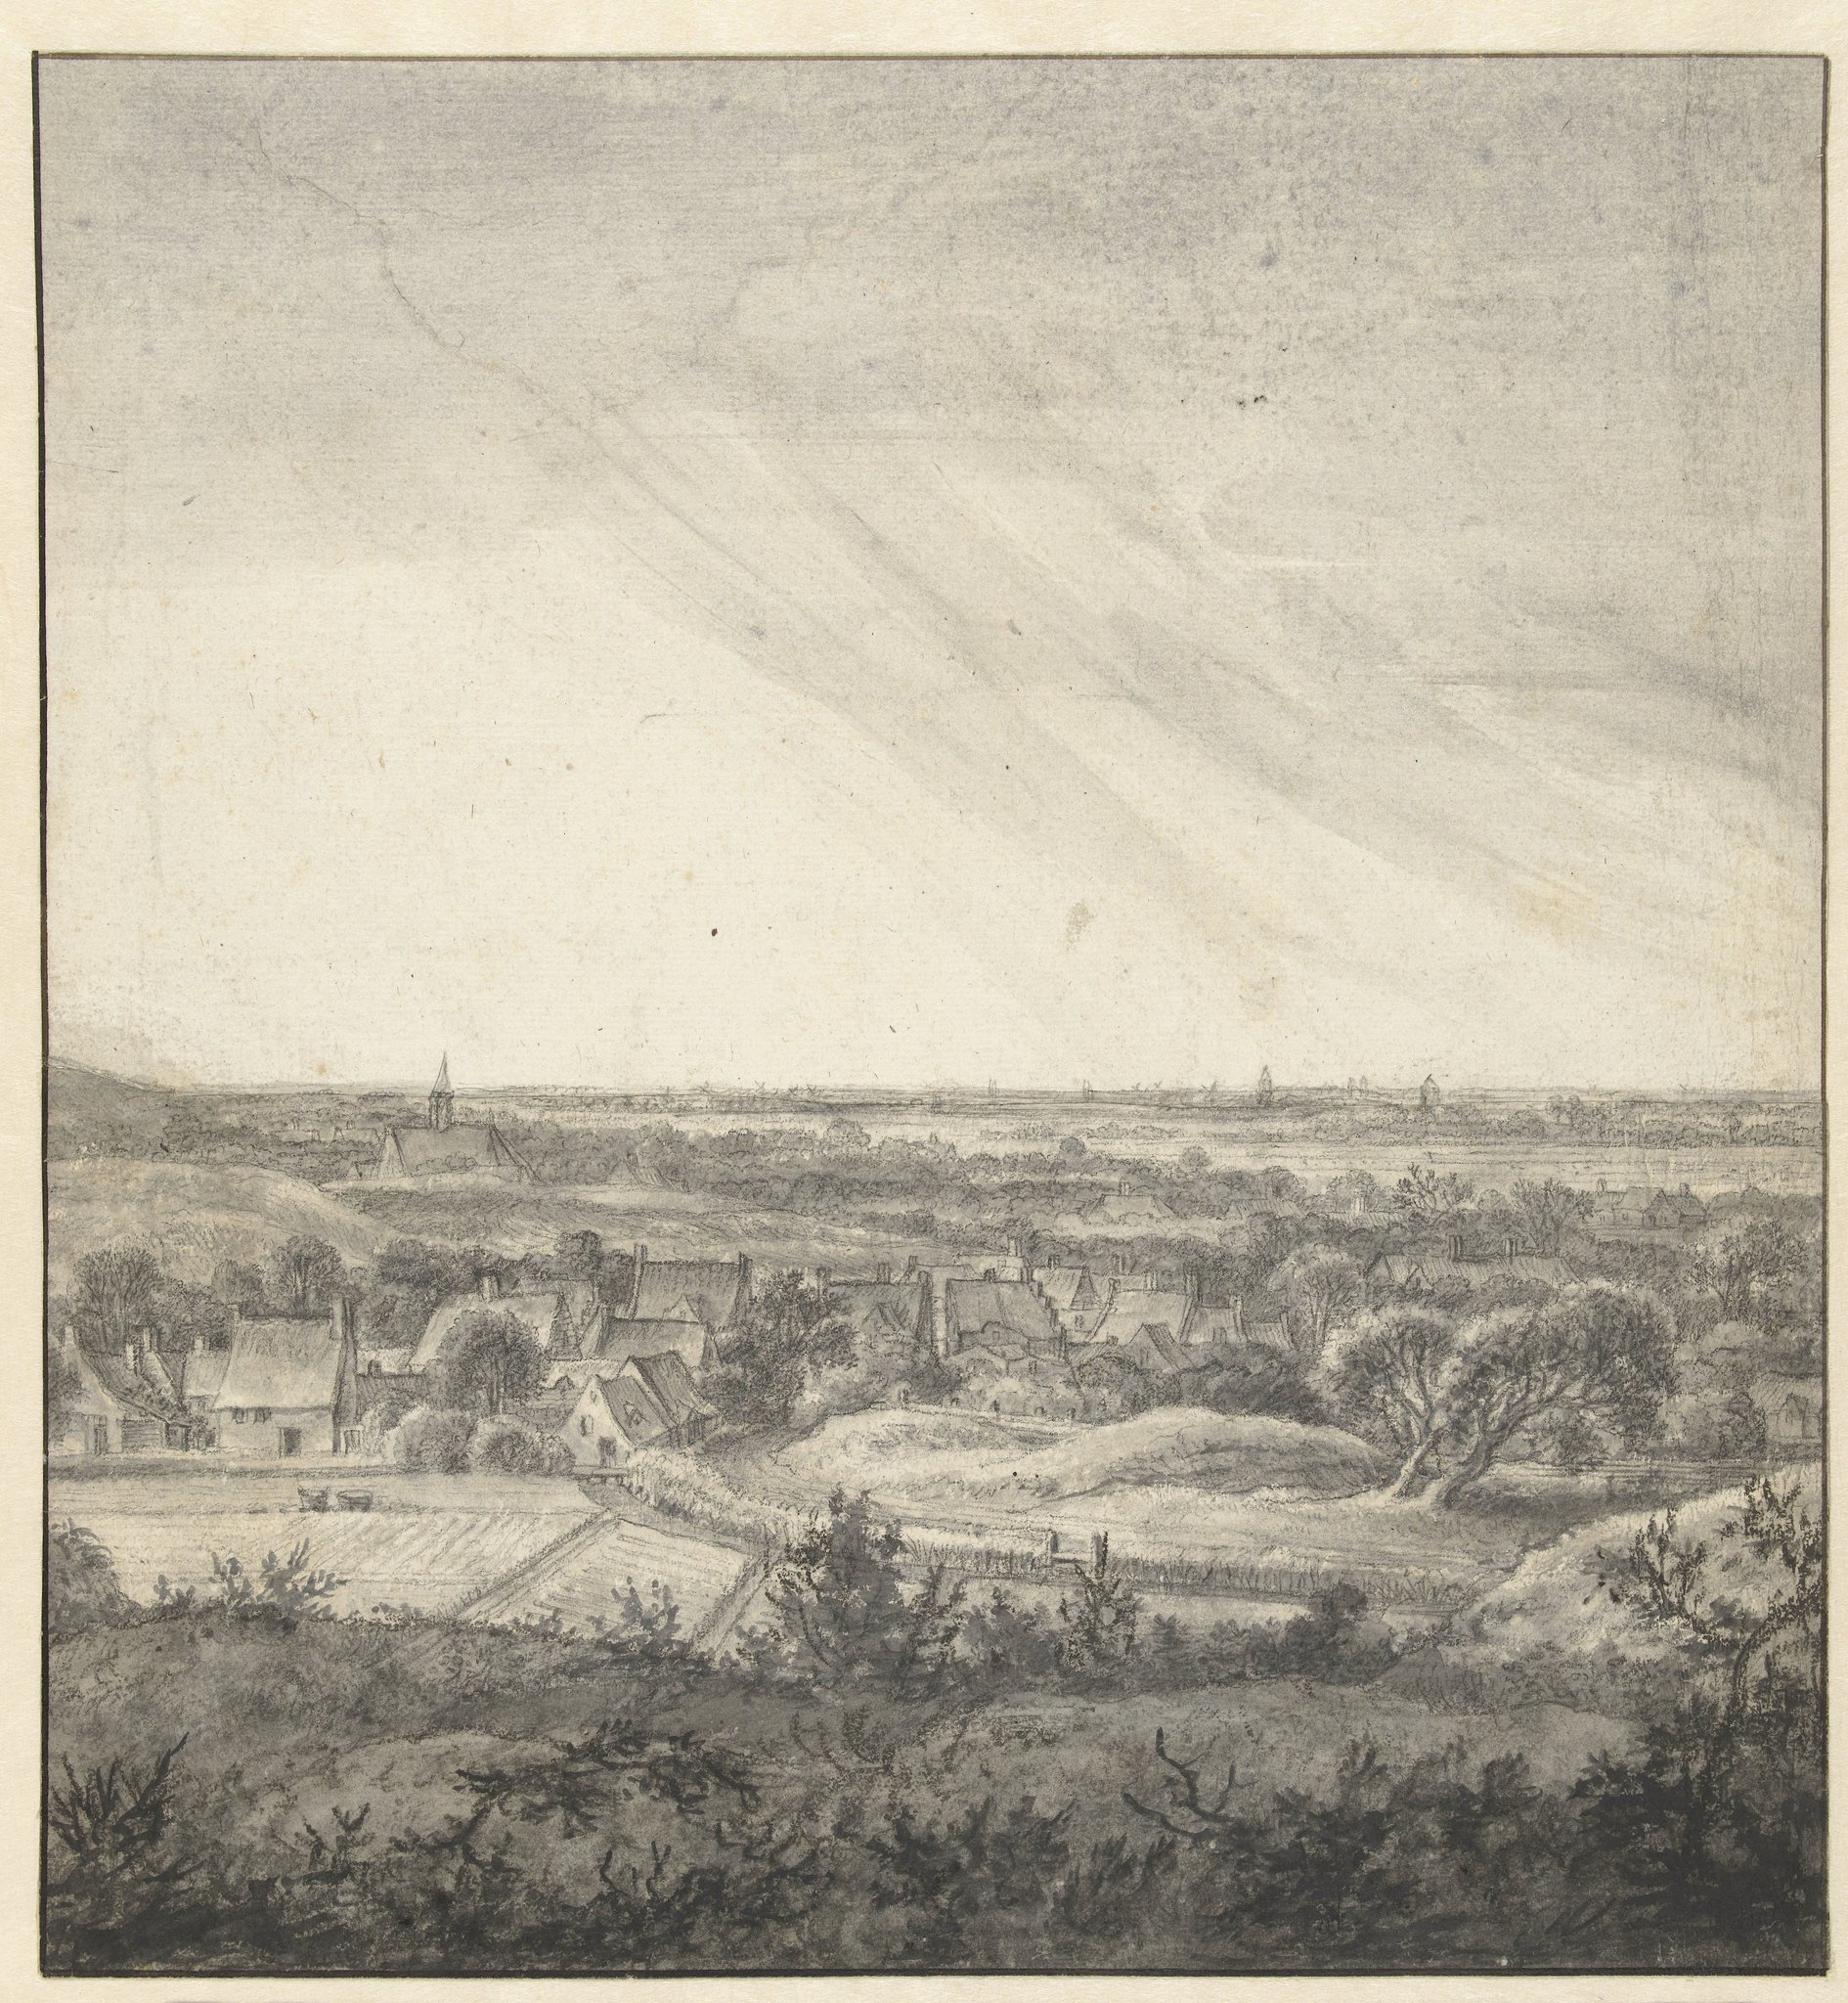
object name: drawing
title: Gezicht vanuit de duinen op Bloemendaal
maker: anthonie waterloo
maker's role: draughtsman, painter, print maker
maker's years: 1609-1690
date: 1619-1690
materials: chalk, charcoal, paper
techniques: brush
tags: prospect of village, silhouette of village, dunes (sea not visible); in the dunes